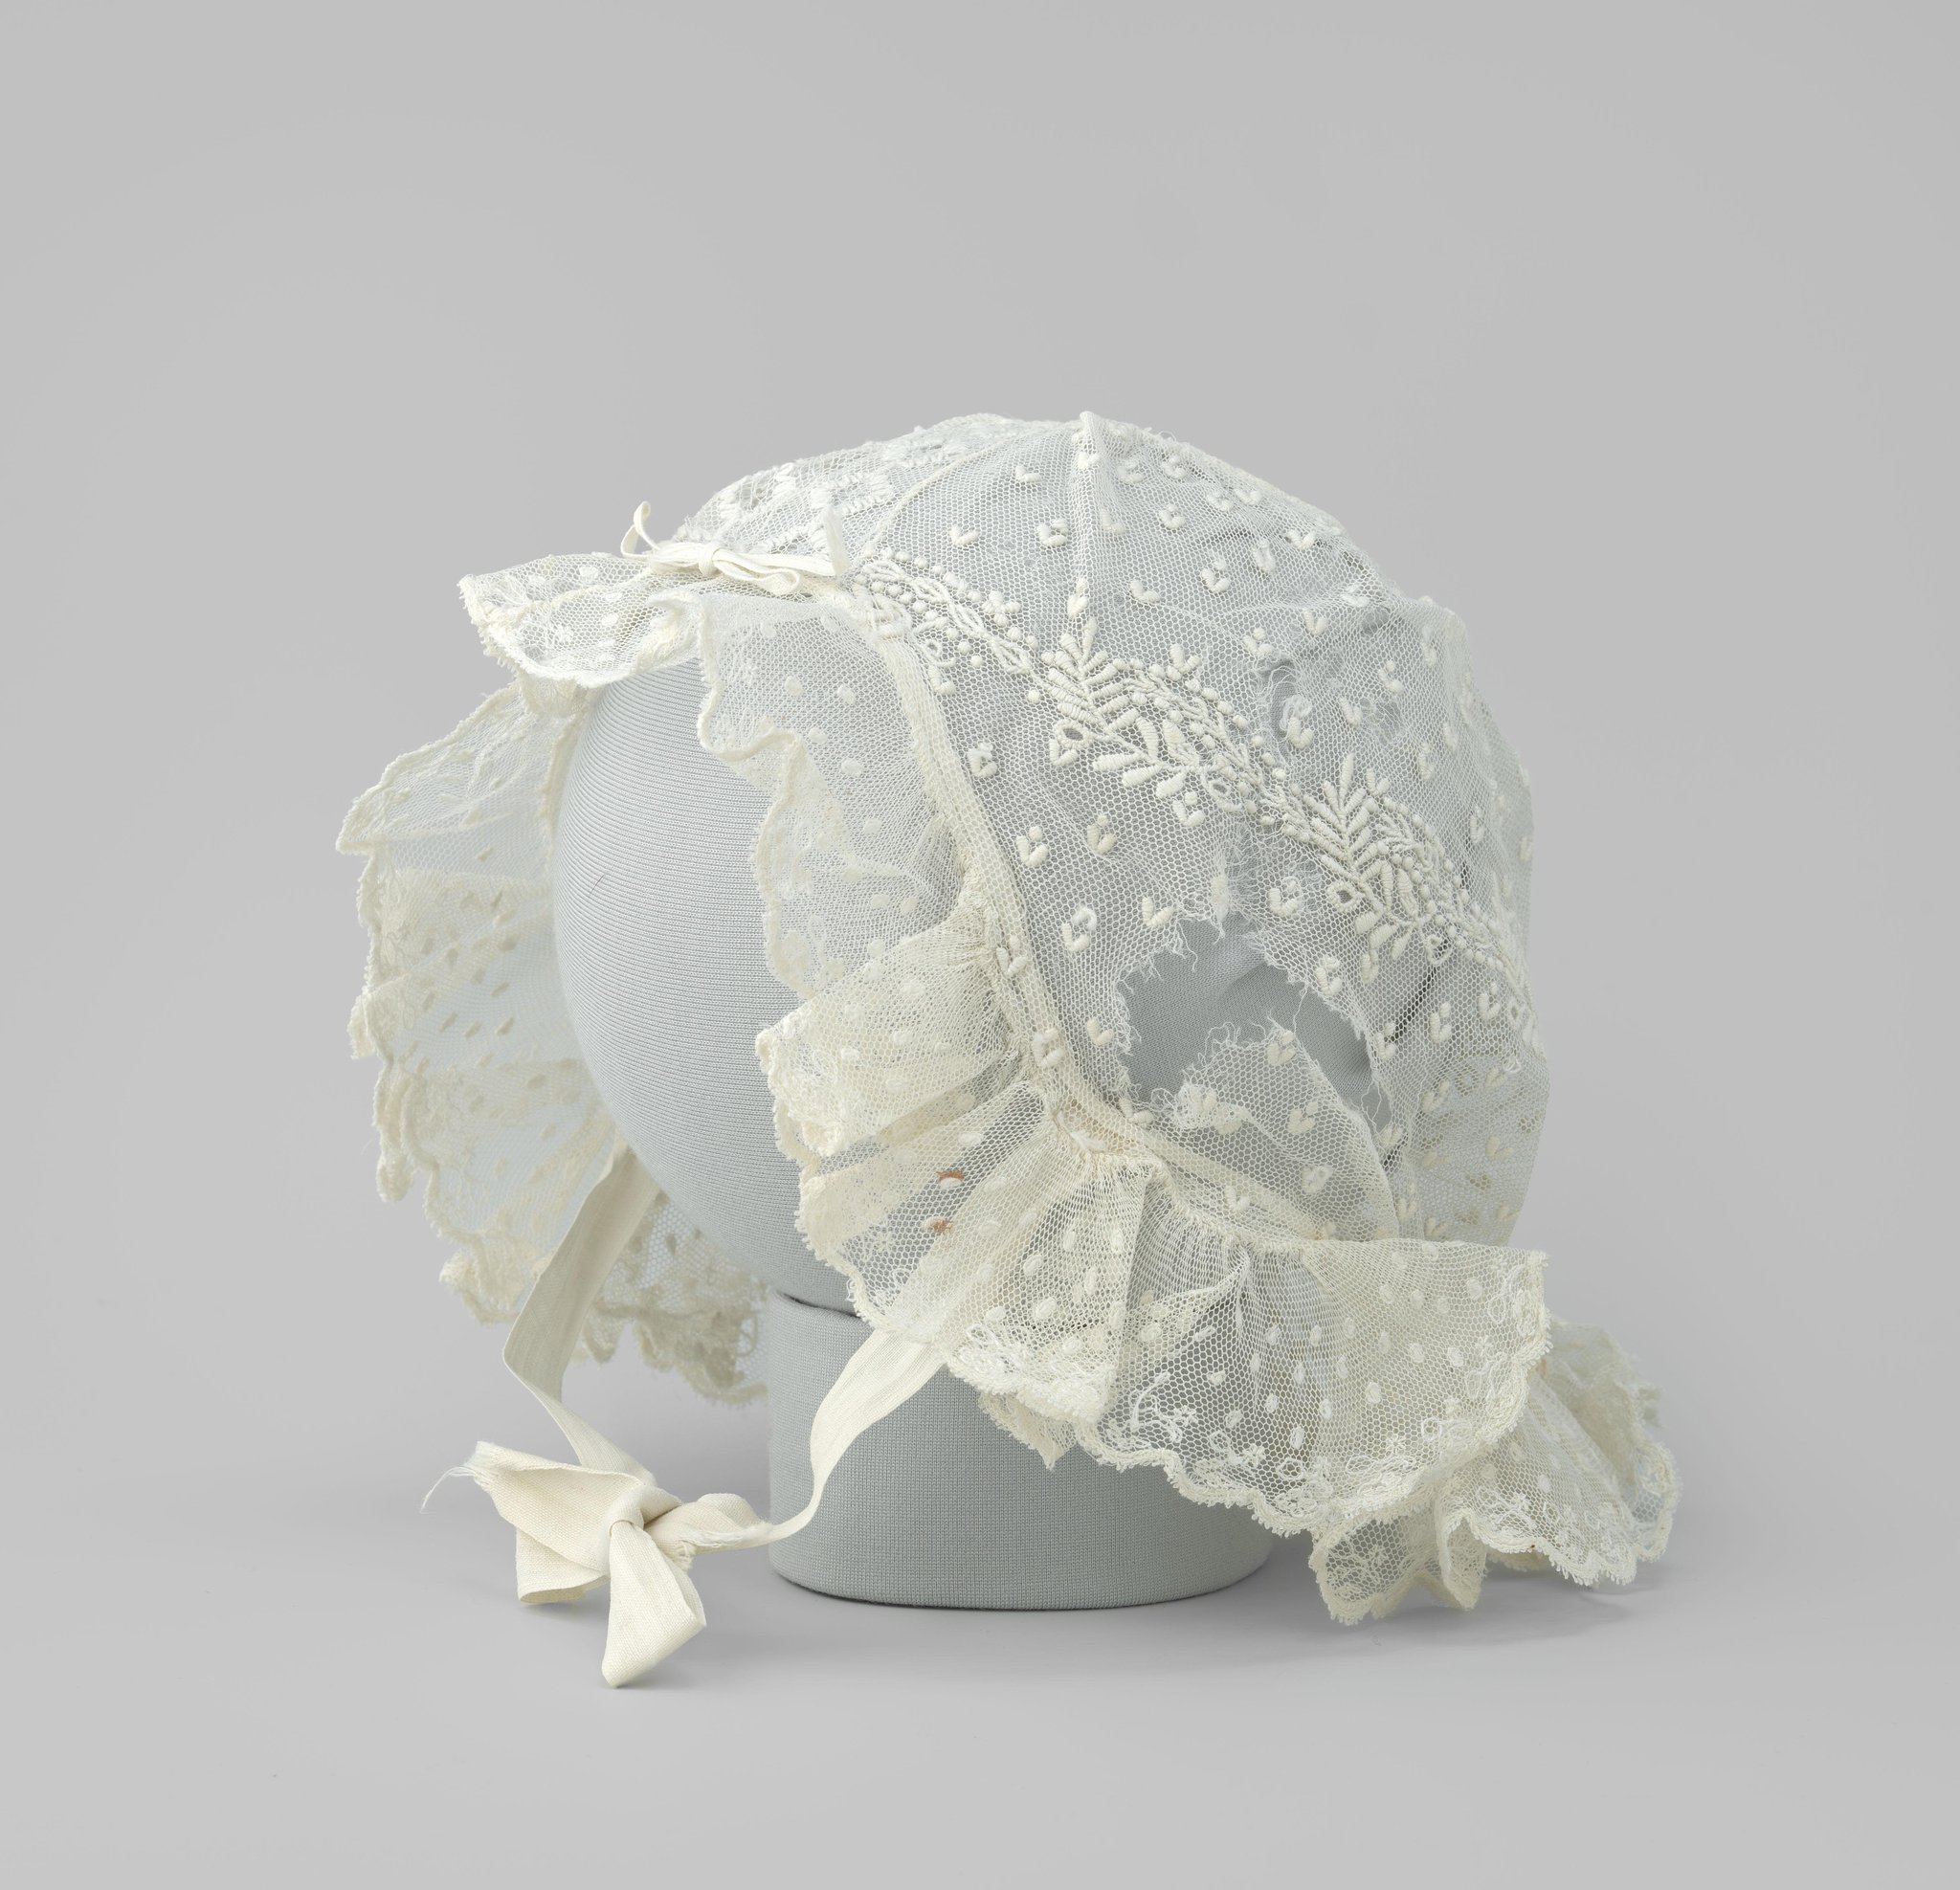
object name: cap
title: Muts van witte tule met moesjes en doorlopende geborduurde tak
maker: Anonymous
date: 1800-1900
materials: lace, fiber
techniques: embroidered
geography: netherlands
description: De muts is afgezet met een strook gerimpeld aangezette geschulpte kant en sluit met twee witte linten.